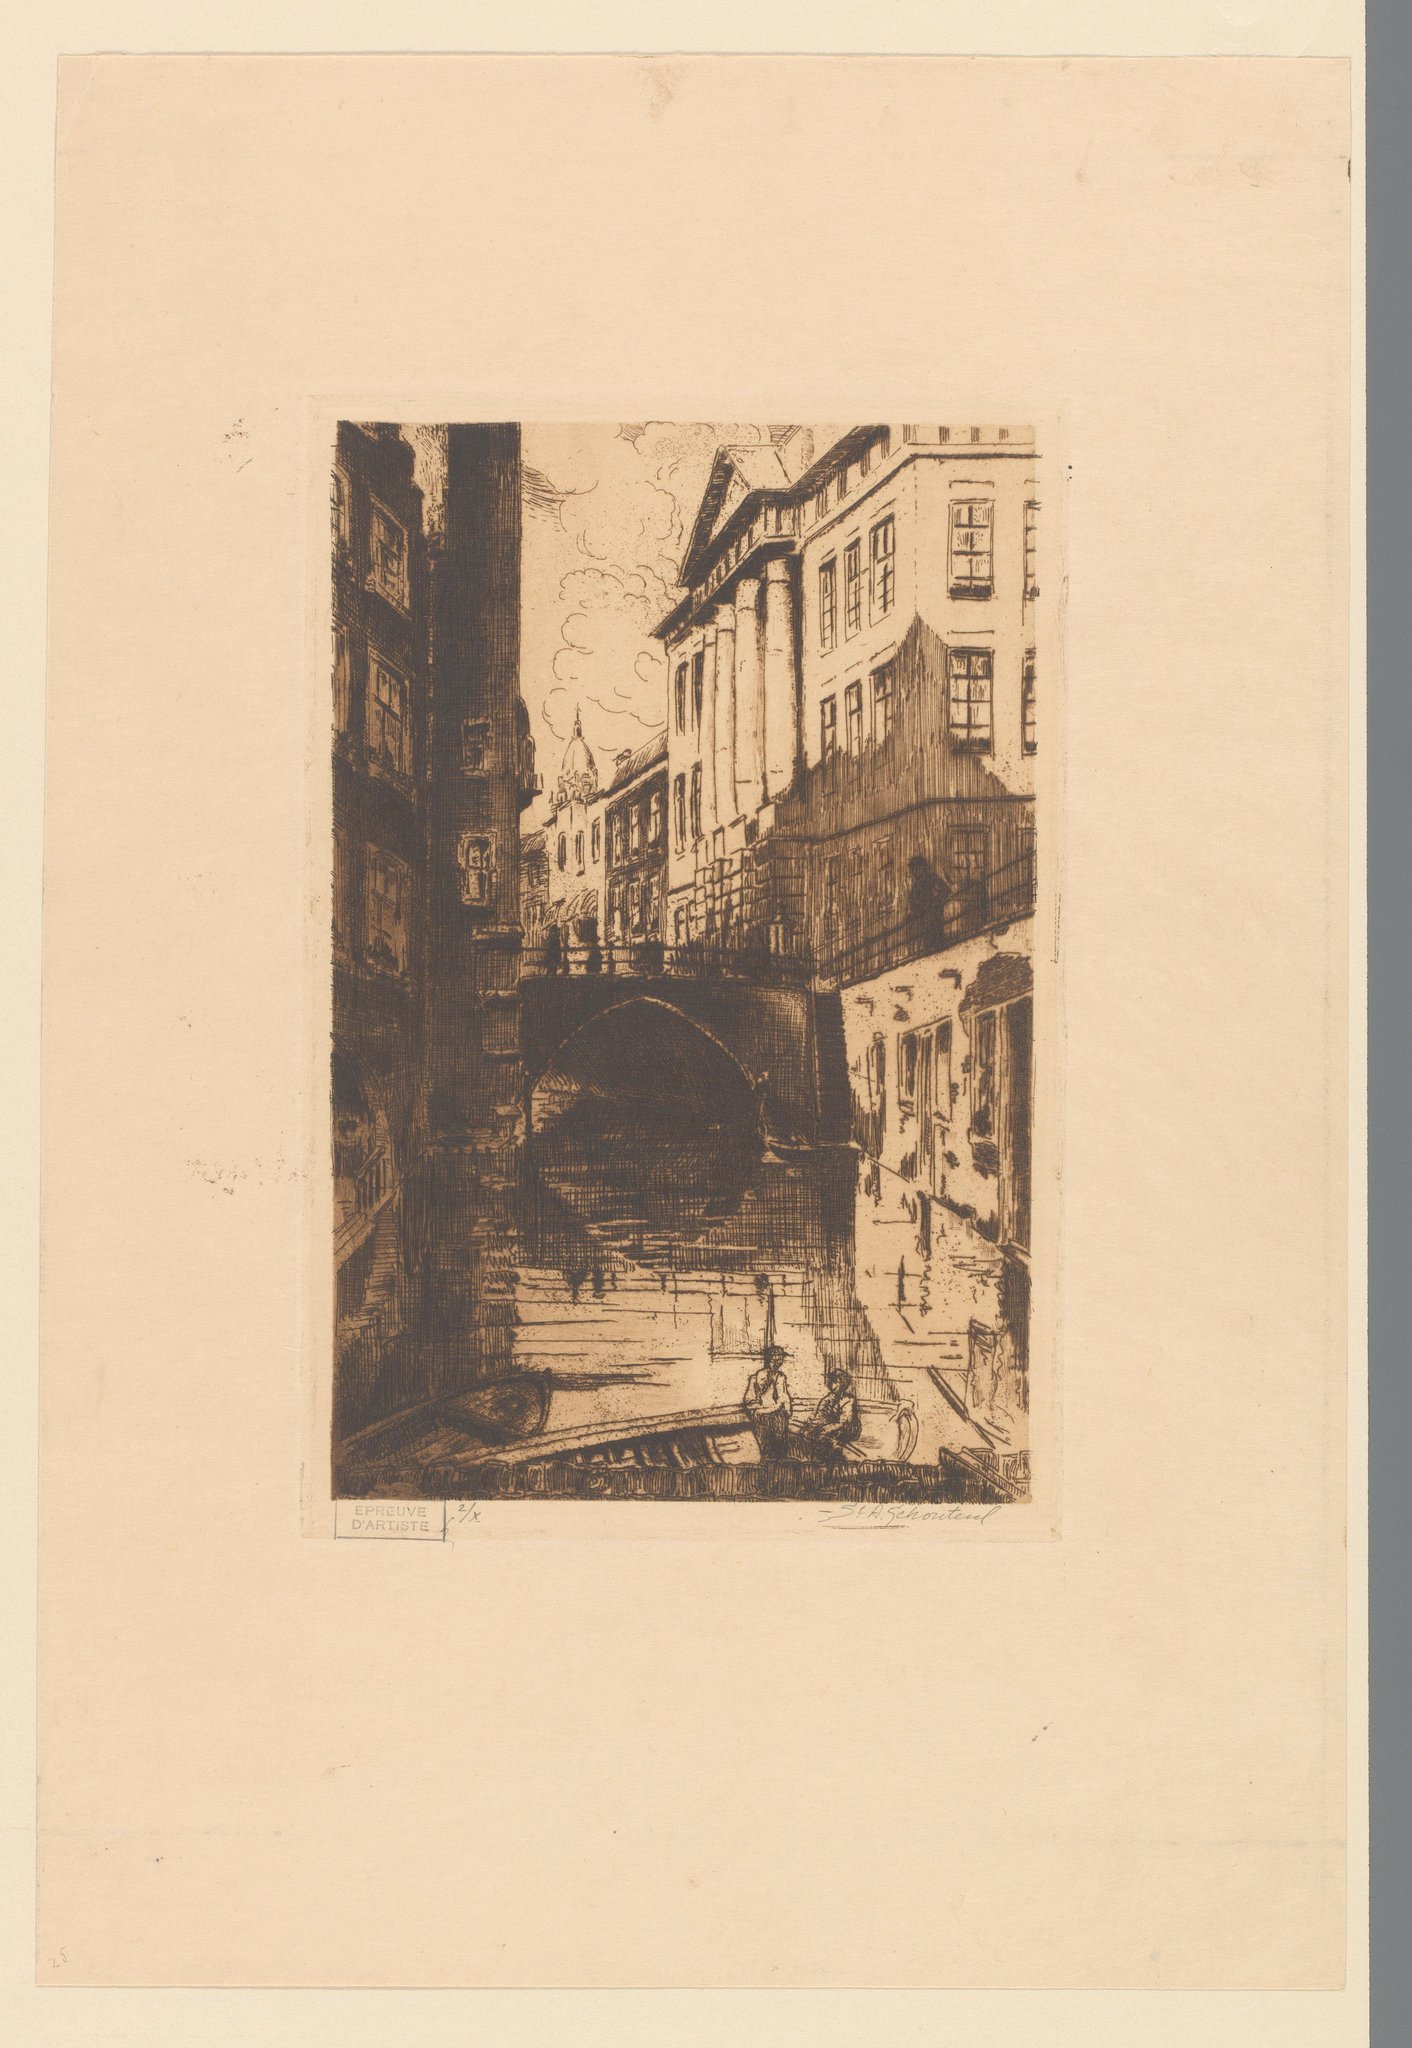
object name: print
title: Stadhuisbrug te Utrecht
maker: st. a. schouten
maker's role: print maker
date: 1928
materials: paper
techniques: etching, intaglio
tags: townhall, bridge in city across river, canal, etc.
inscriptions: annotation: ‘Epreuve d'artiste’, annotation: ‘(n. schets van 1912)’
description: Aangezien geboorte- en sterfdatum van de kunstenaar onbekend zijn, is voor de rechtenbepaling van dit object de productiedatum gehanteerd. De titel van deze prent is overgenomen van de rekening voor deze prenten, door de kunstenaar geschreven.